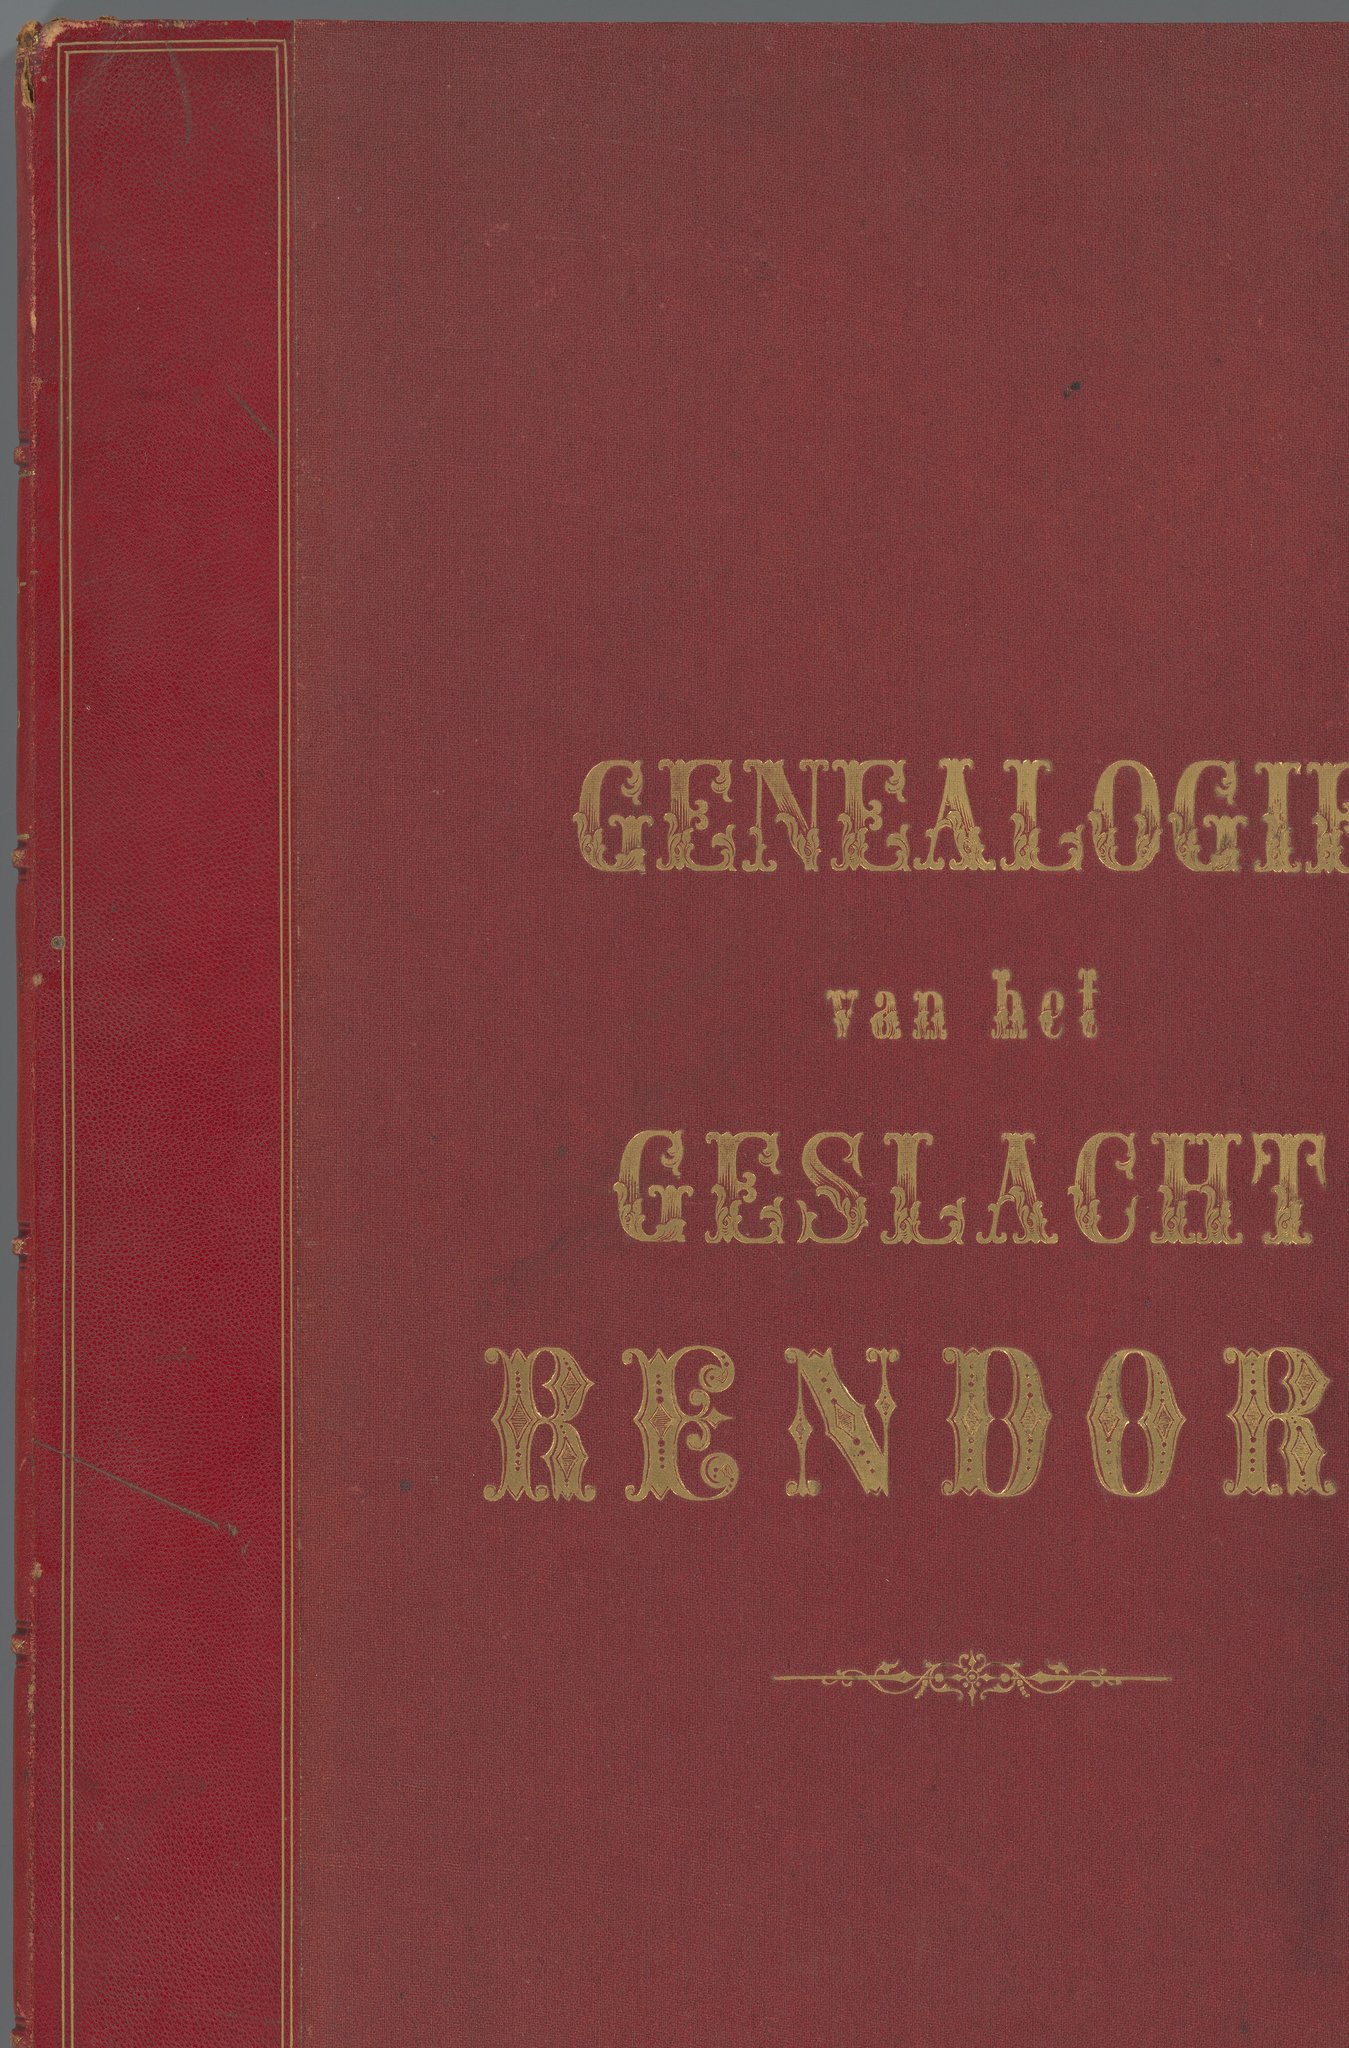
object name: manuscript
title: Genealogie van het geslacht Rendorp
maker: Anonymous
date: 1837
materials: paint, paper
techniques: brush, writing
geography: the hague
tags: rendorp, familie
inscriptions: : ‘GENEALOGIE van het GESLACHT RENDORP’, : ‘GENEALOGIE’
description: Handgeschreven gebonden genealogisch overzicht van elf generaties Rendorp. In rood linnen band met opdruk in goud en rug en hoeken versterkt met rood leer. Na een inleiding over de oorsprong en afkomst van het geslacht Rendorp volgt een beschrijving en afbeelding van het familiewapen, een inhoudsopgave, een naamlijst en per generatie een beschrijving van de huwelijkspartner, hun kinderen, de gerelateerde familiewapens in kleur en andere bijzonderheden omtrent opleiding of beroep.